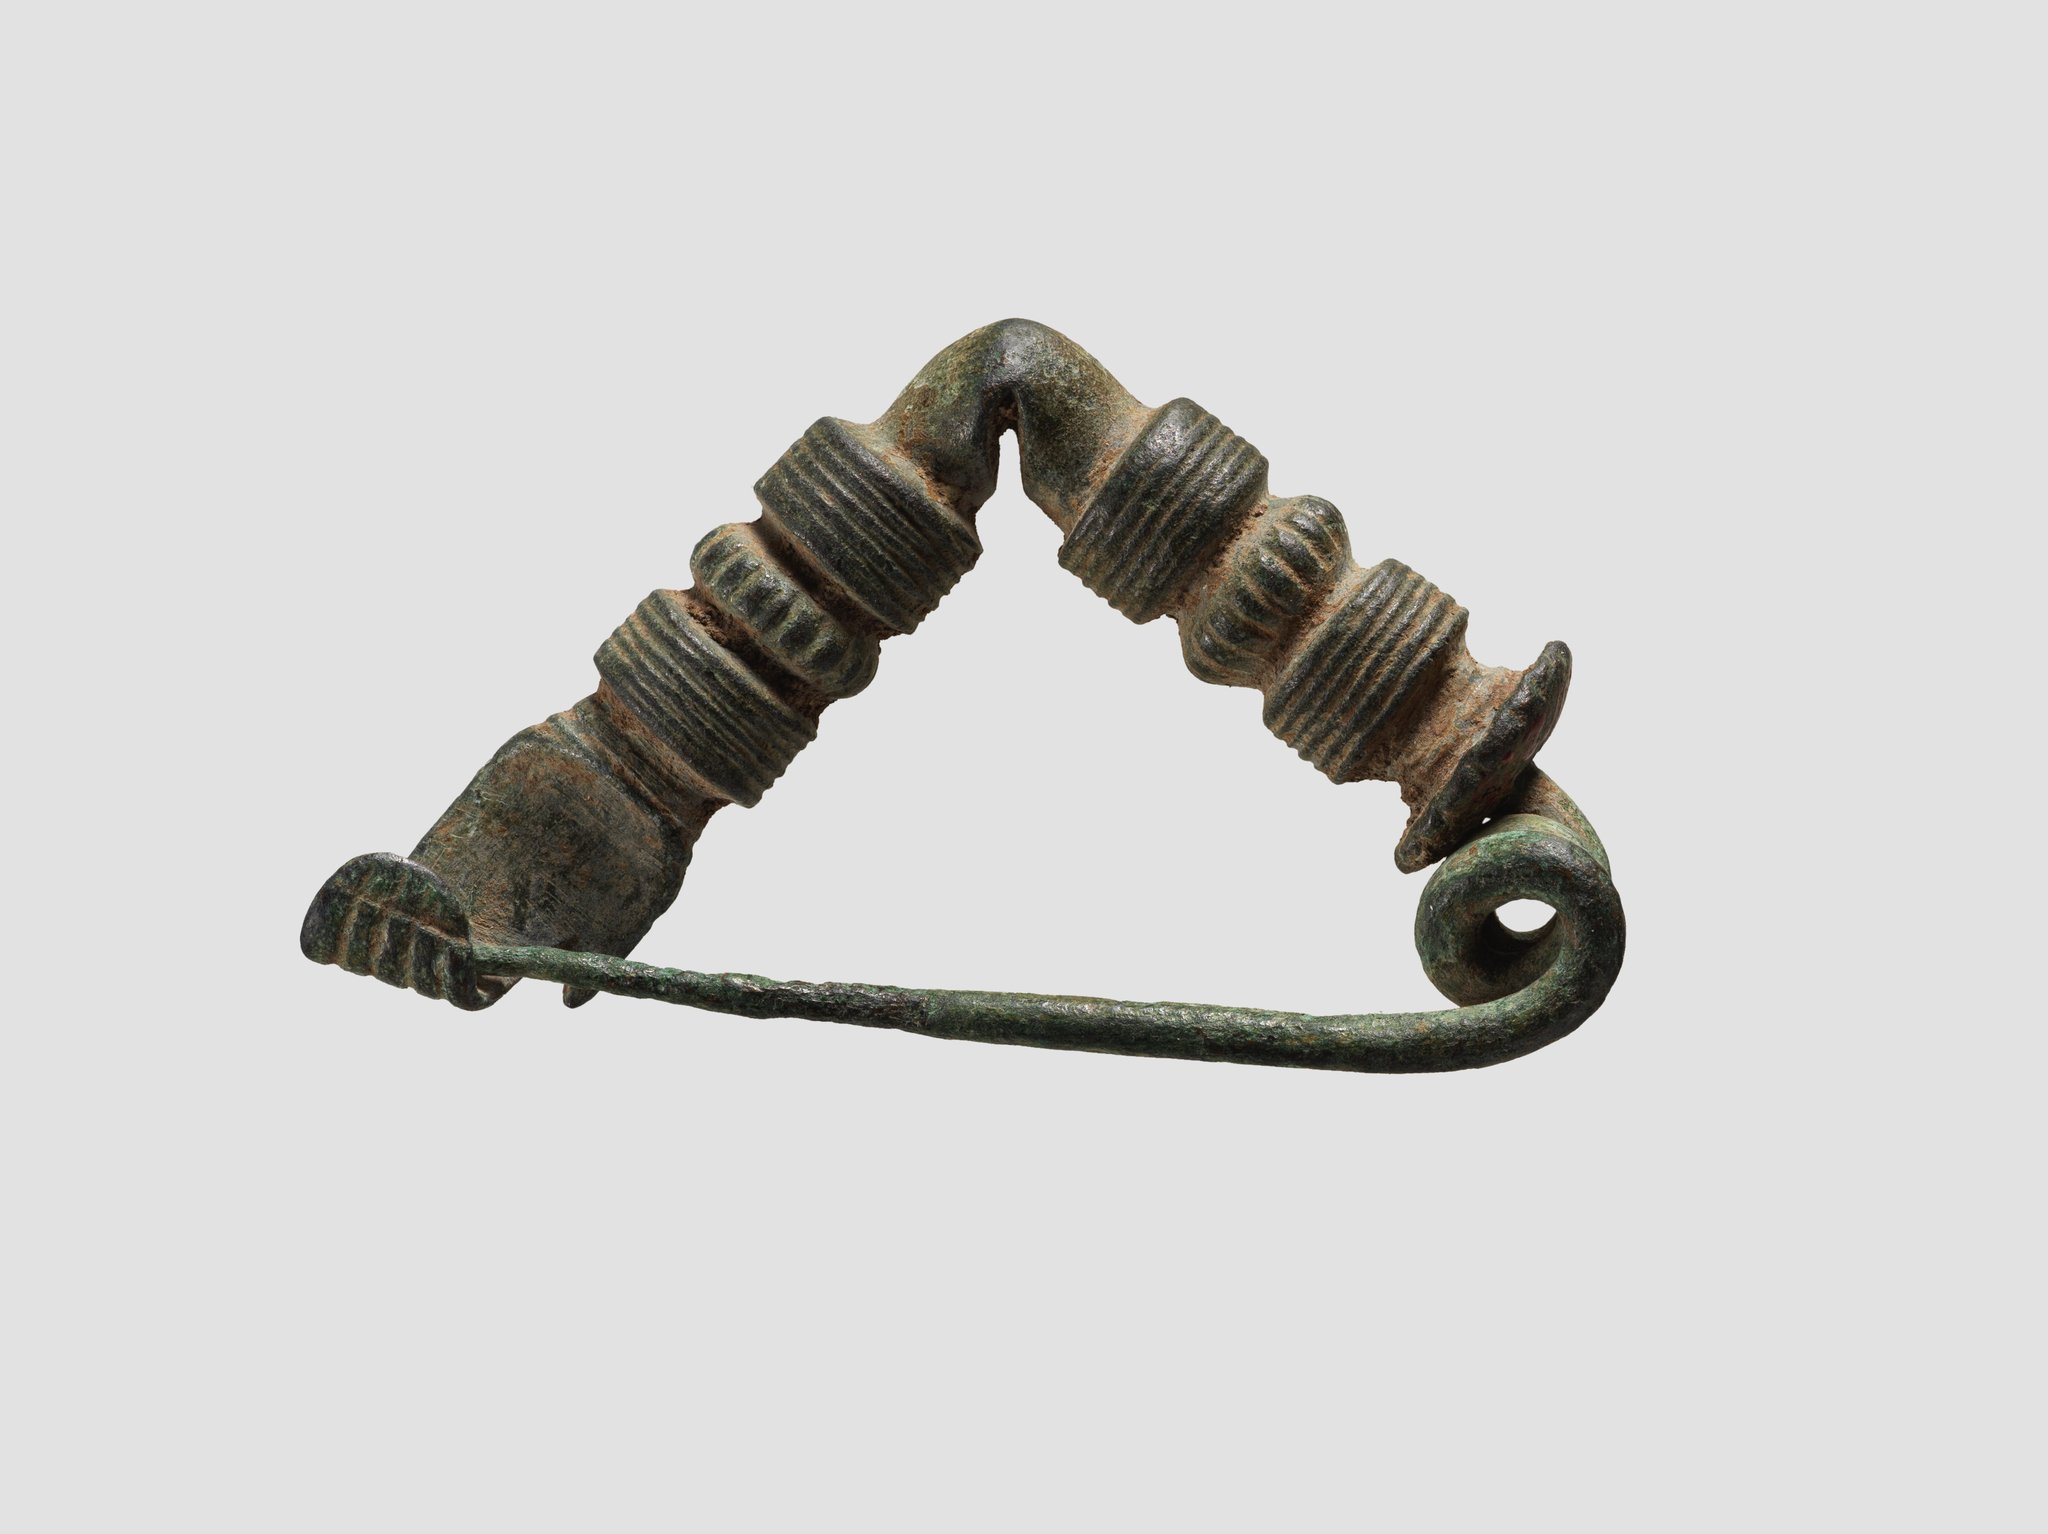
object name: fibula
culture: iranian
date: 700-501 BCE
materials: bronze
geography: western asia